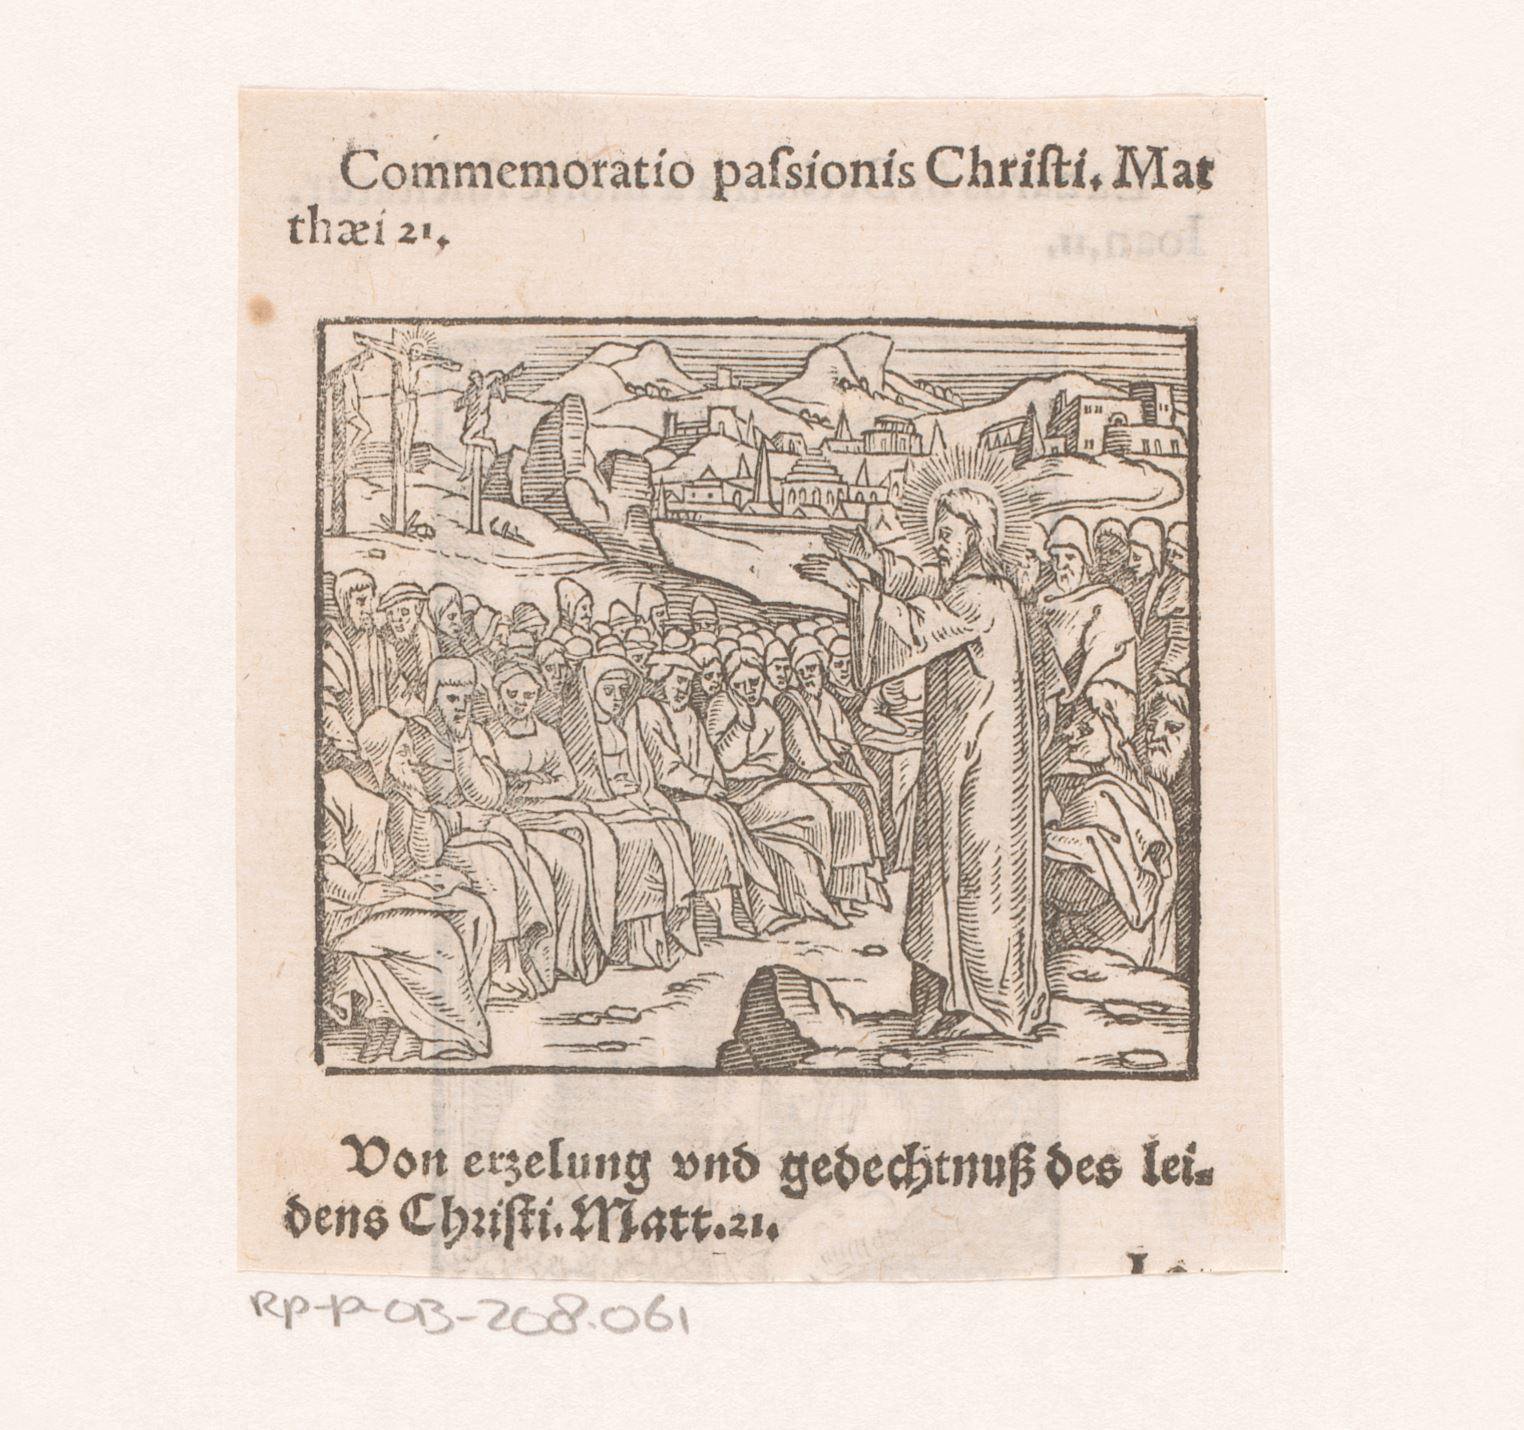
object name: print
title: Vertelling van het lijdensverhaal van Christus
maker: Anonymous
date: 1600-1699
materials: paper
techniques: letterpress printing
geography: netherlands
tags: passion of christ